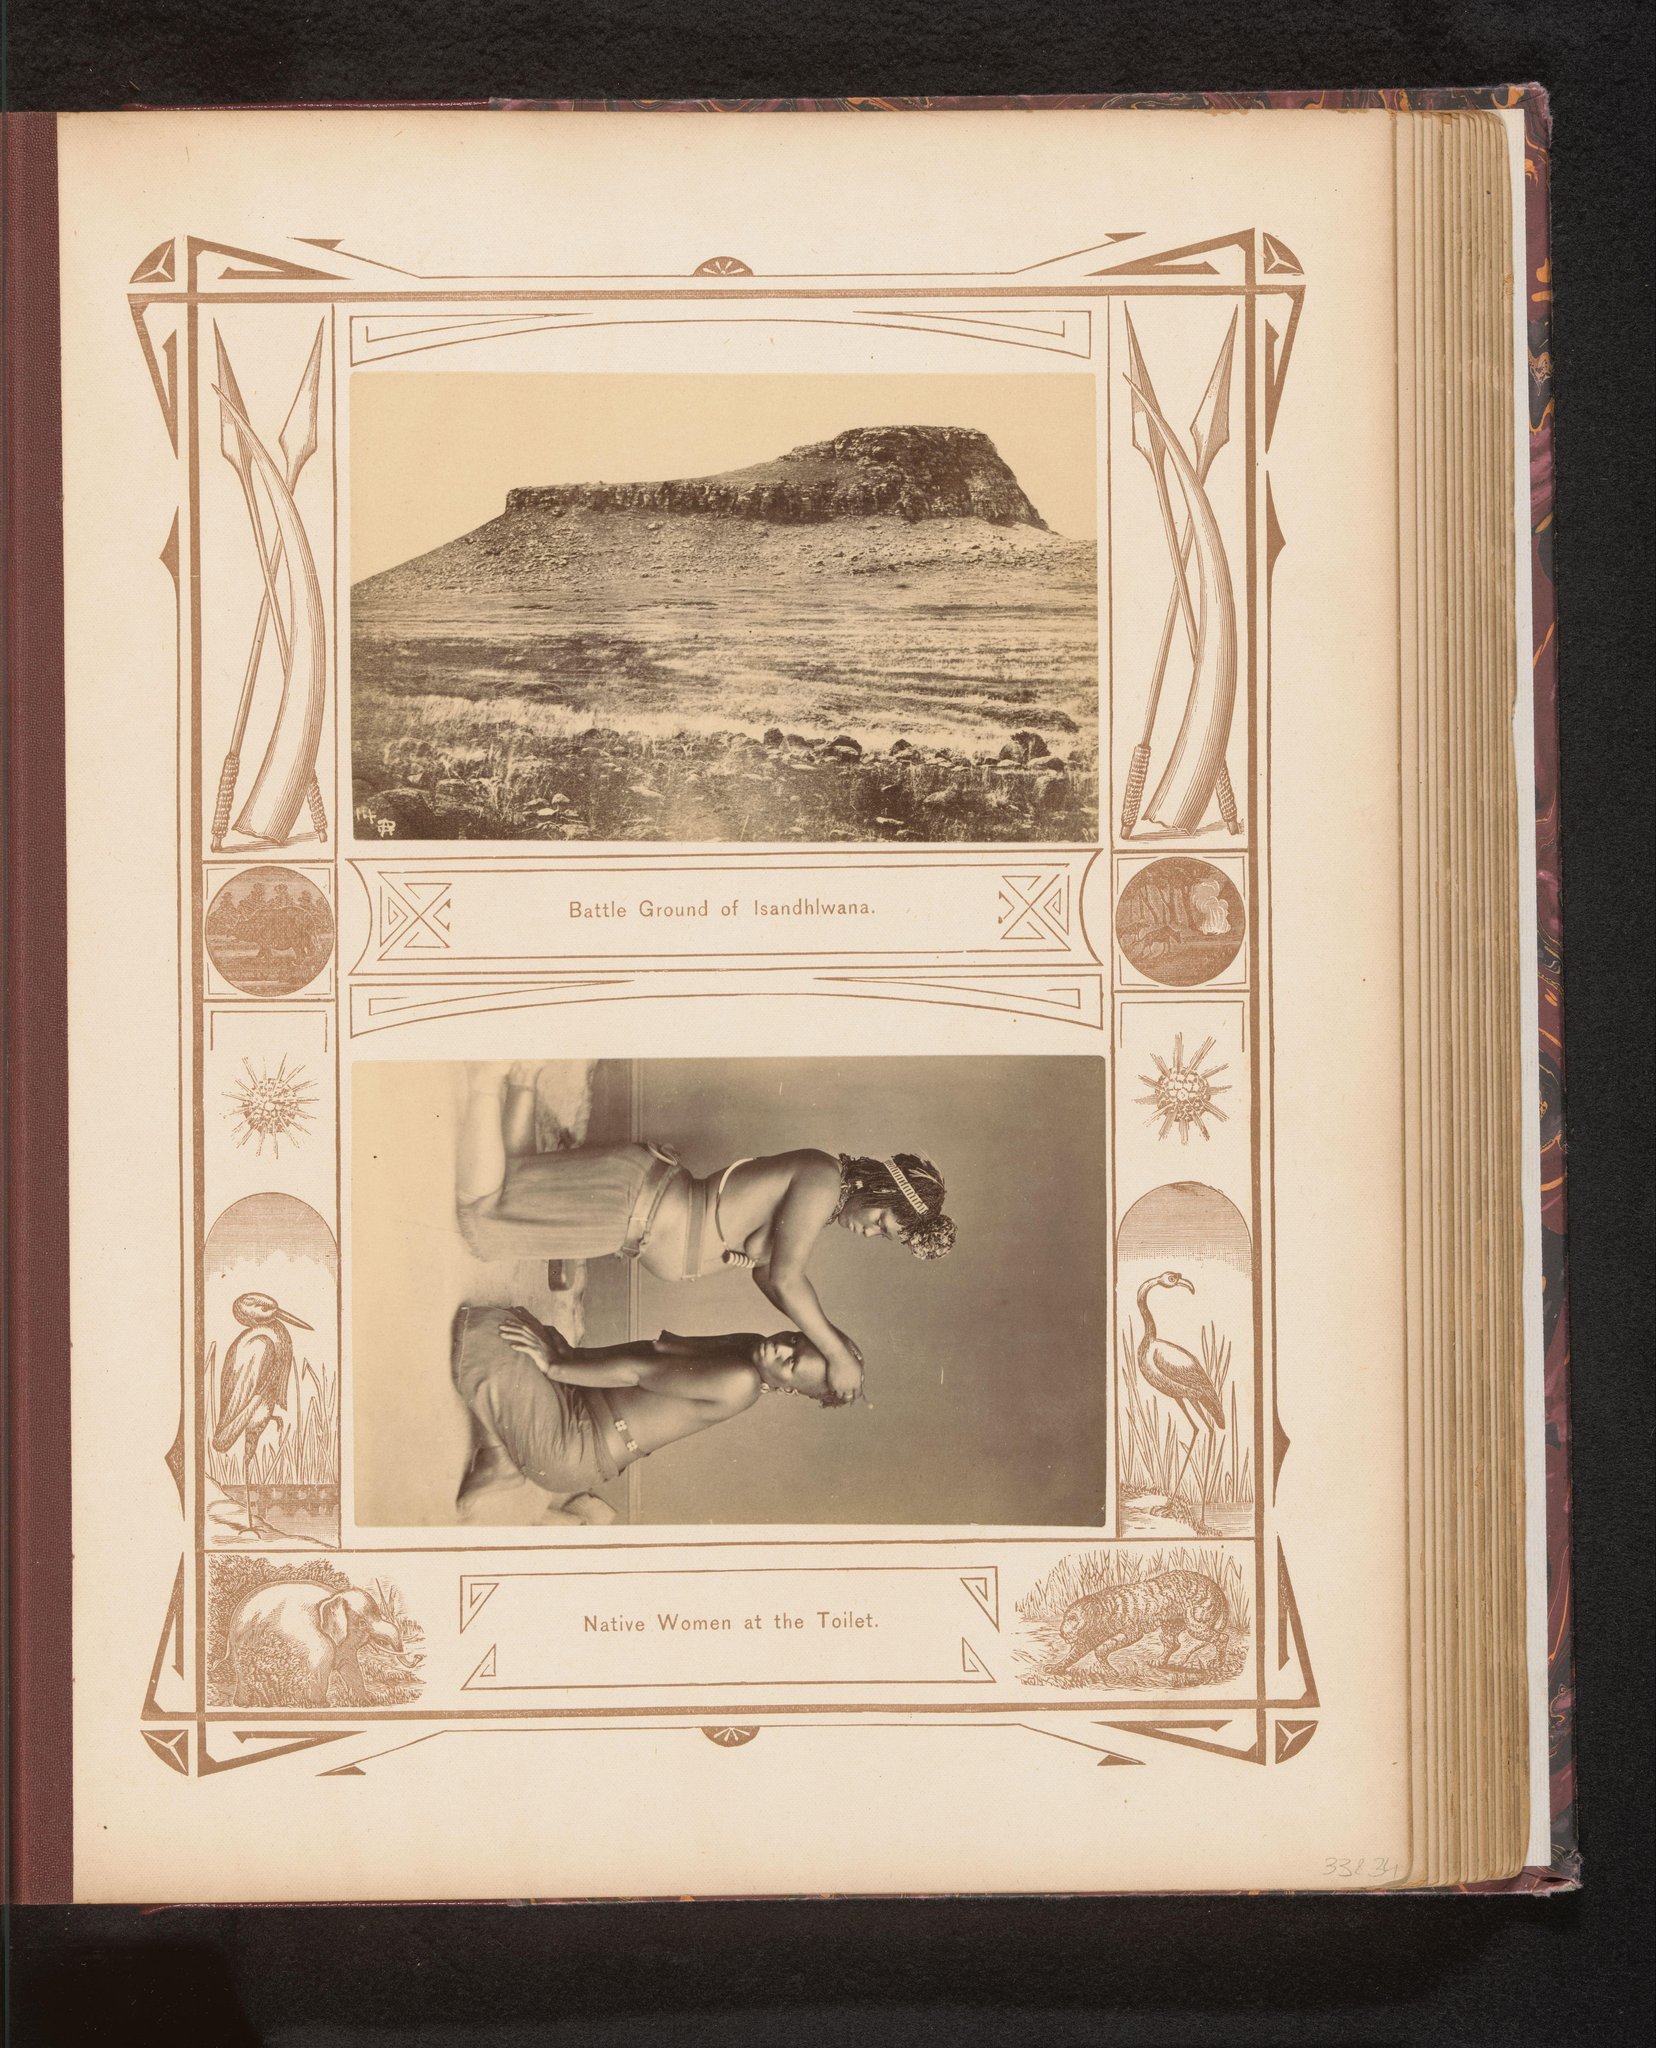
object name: photograph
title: Battle ground of Isandhlwana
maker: Anonymous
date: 1877-1882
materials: photographic support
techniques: albumen print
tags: (high) hill